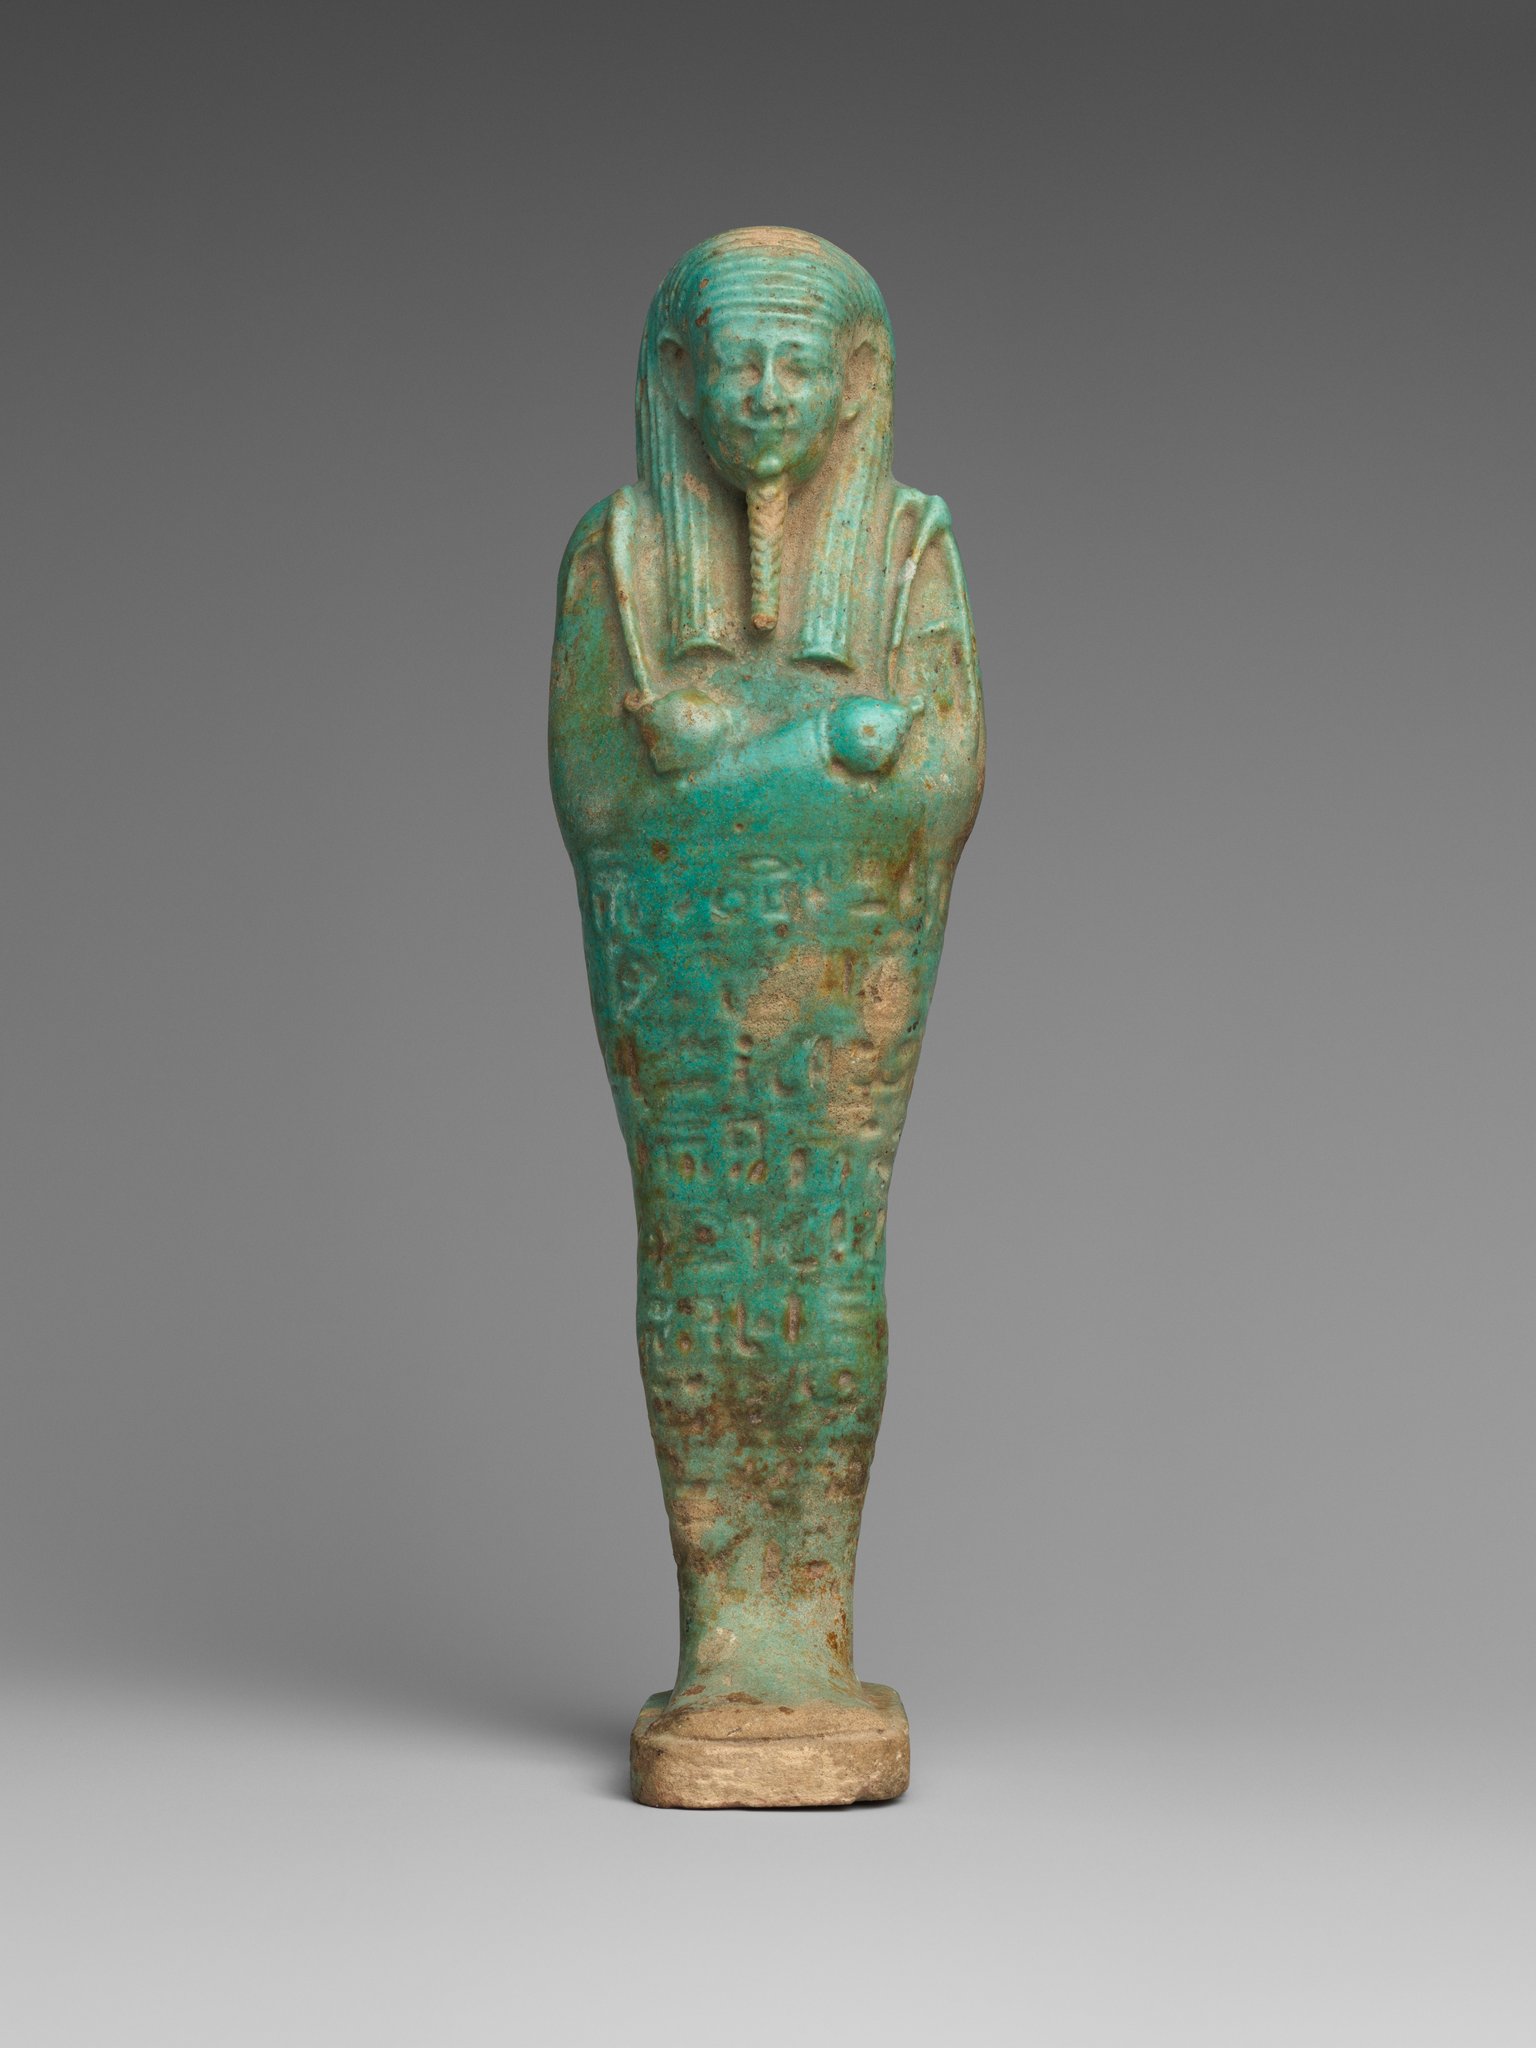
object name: shabti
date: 688-332 BCE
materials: faience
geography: egypt